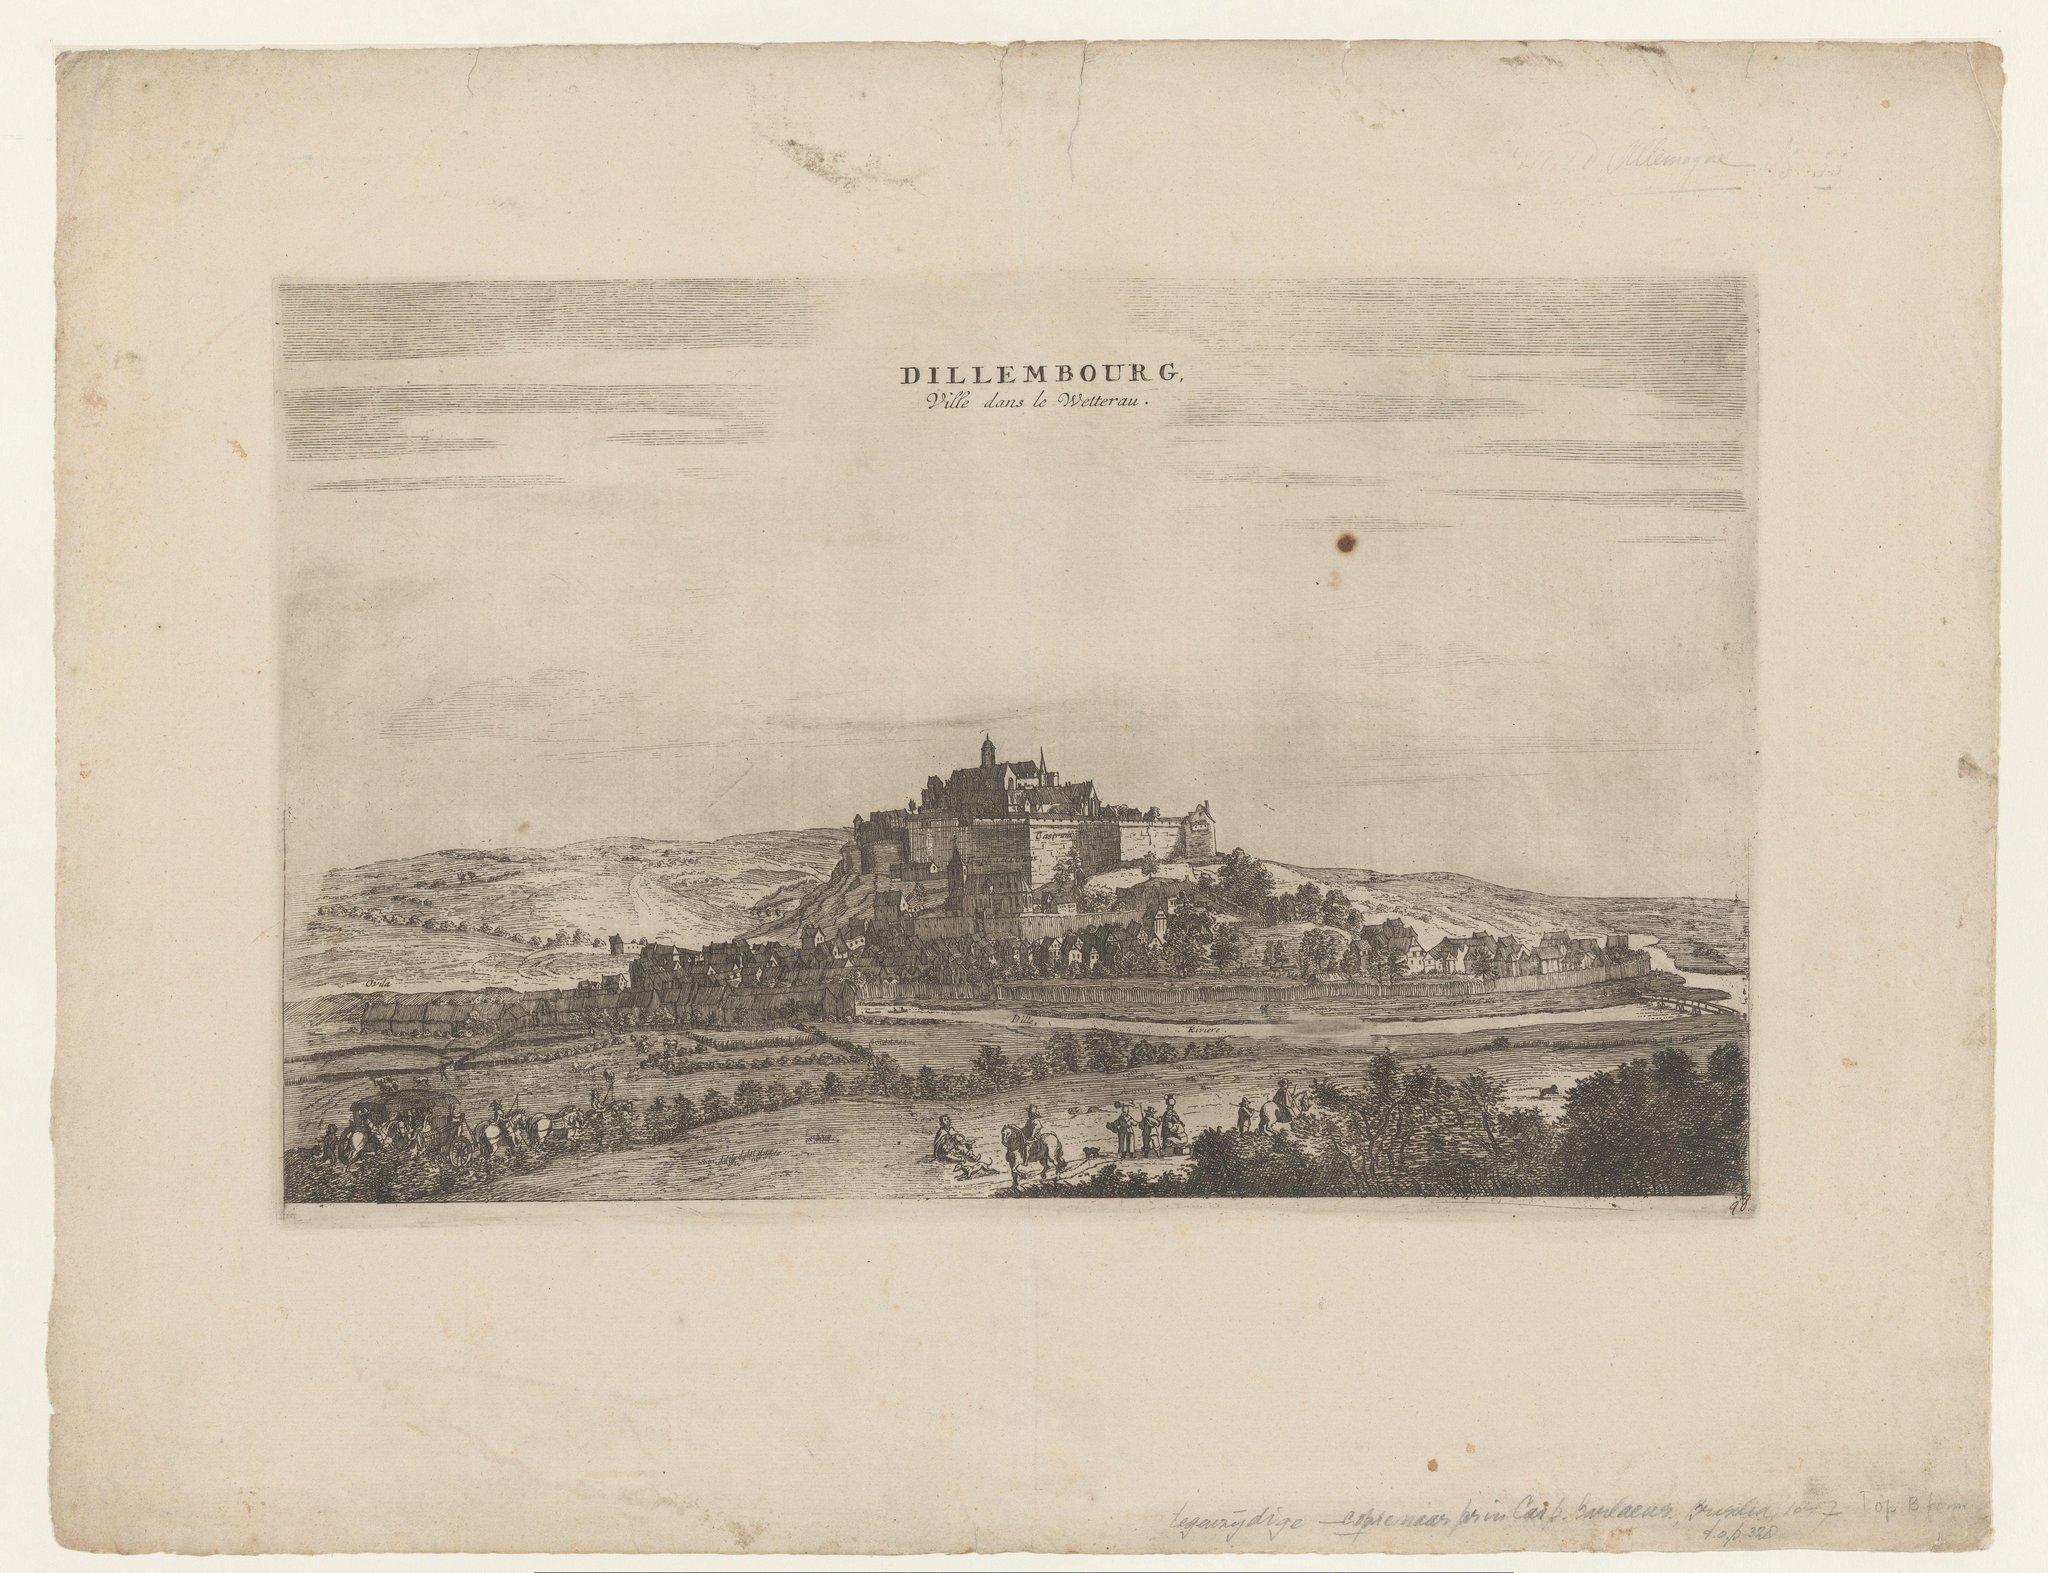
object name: print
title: Dillembourg, ville dans le Wetterau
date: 1728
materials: paper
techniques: engraving, etching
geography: amsterdam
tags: prospect of village, silhouette of village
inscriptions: collector's mark: Lugt 2228